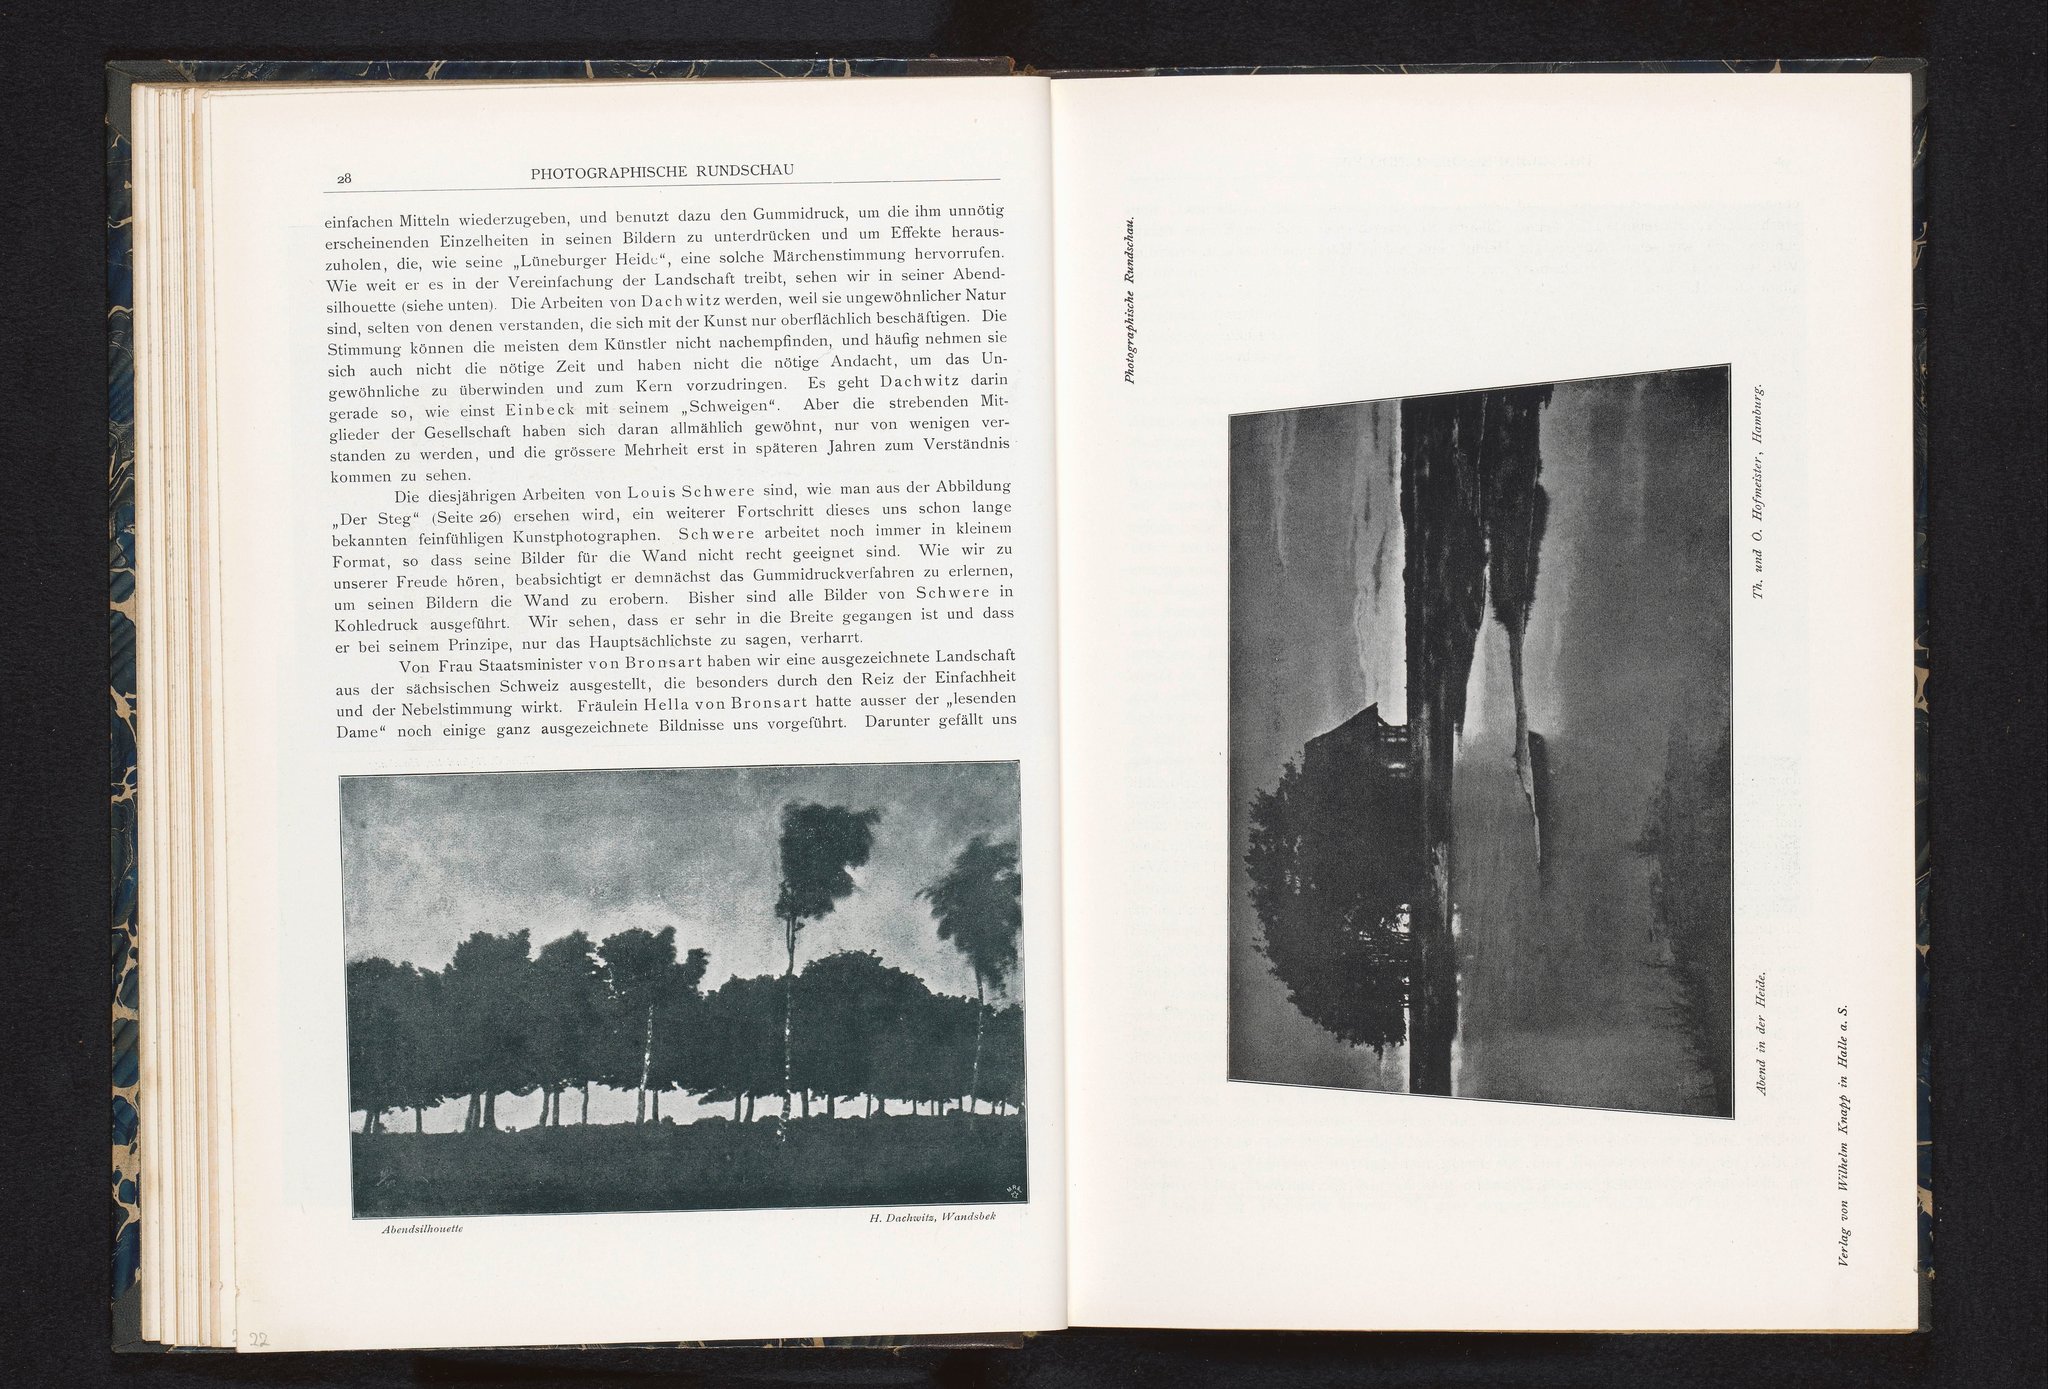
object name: photomechanical print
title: Silhouet van bomen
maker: hugo dachwitz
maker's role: fotograaf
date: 1896-1901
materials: paper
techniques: autotype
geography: berlin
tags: trees, landscapes